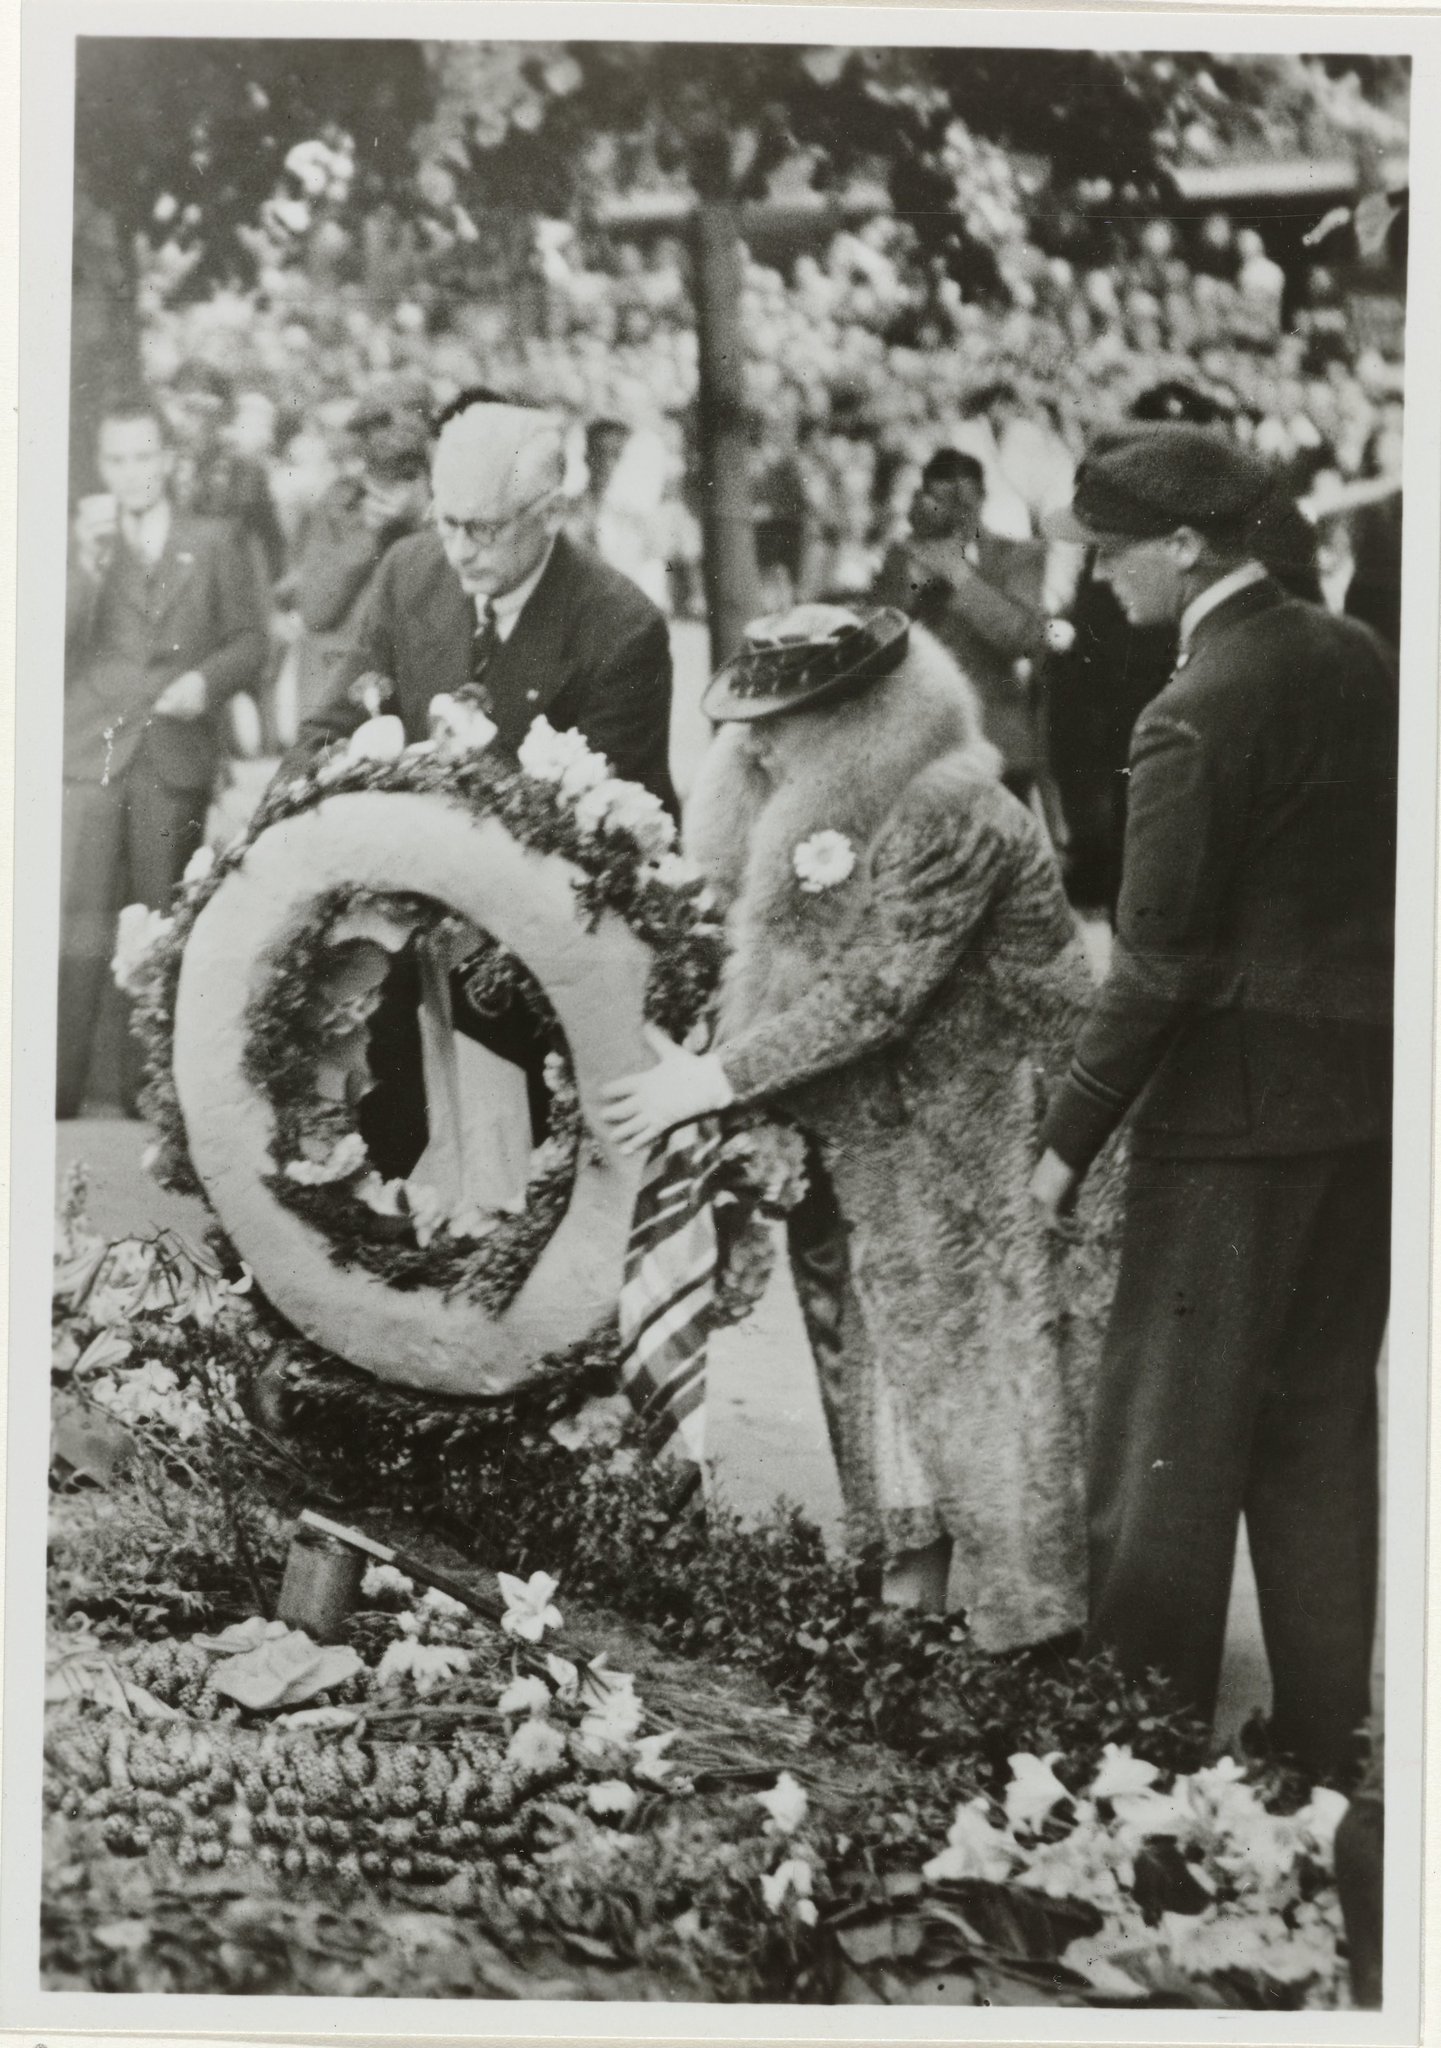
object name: photograph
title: Kranslegging door Wilhelmina, koningin der Nederlanden, en Feike de Boer in de Apollolaan te Amsterdam bij de bevrijdingsfeesten op 28 juni 1945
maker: noordhoff. e.j.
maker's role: fotograaf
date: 1945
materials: photographic support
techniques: photography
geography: amsterdam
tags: the hague, print maker, wilhelmina of the netherlands, amsterdam, politician, mayor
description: De hier vermelde titel verwijst naar de hoogst verkregen titel van de geportretteerde, niet per se naar de titel die de geportretteerde op deze voorstelling draagt.